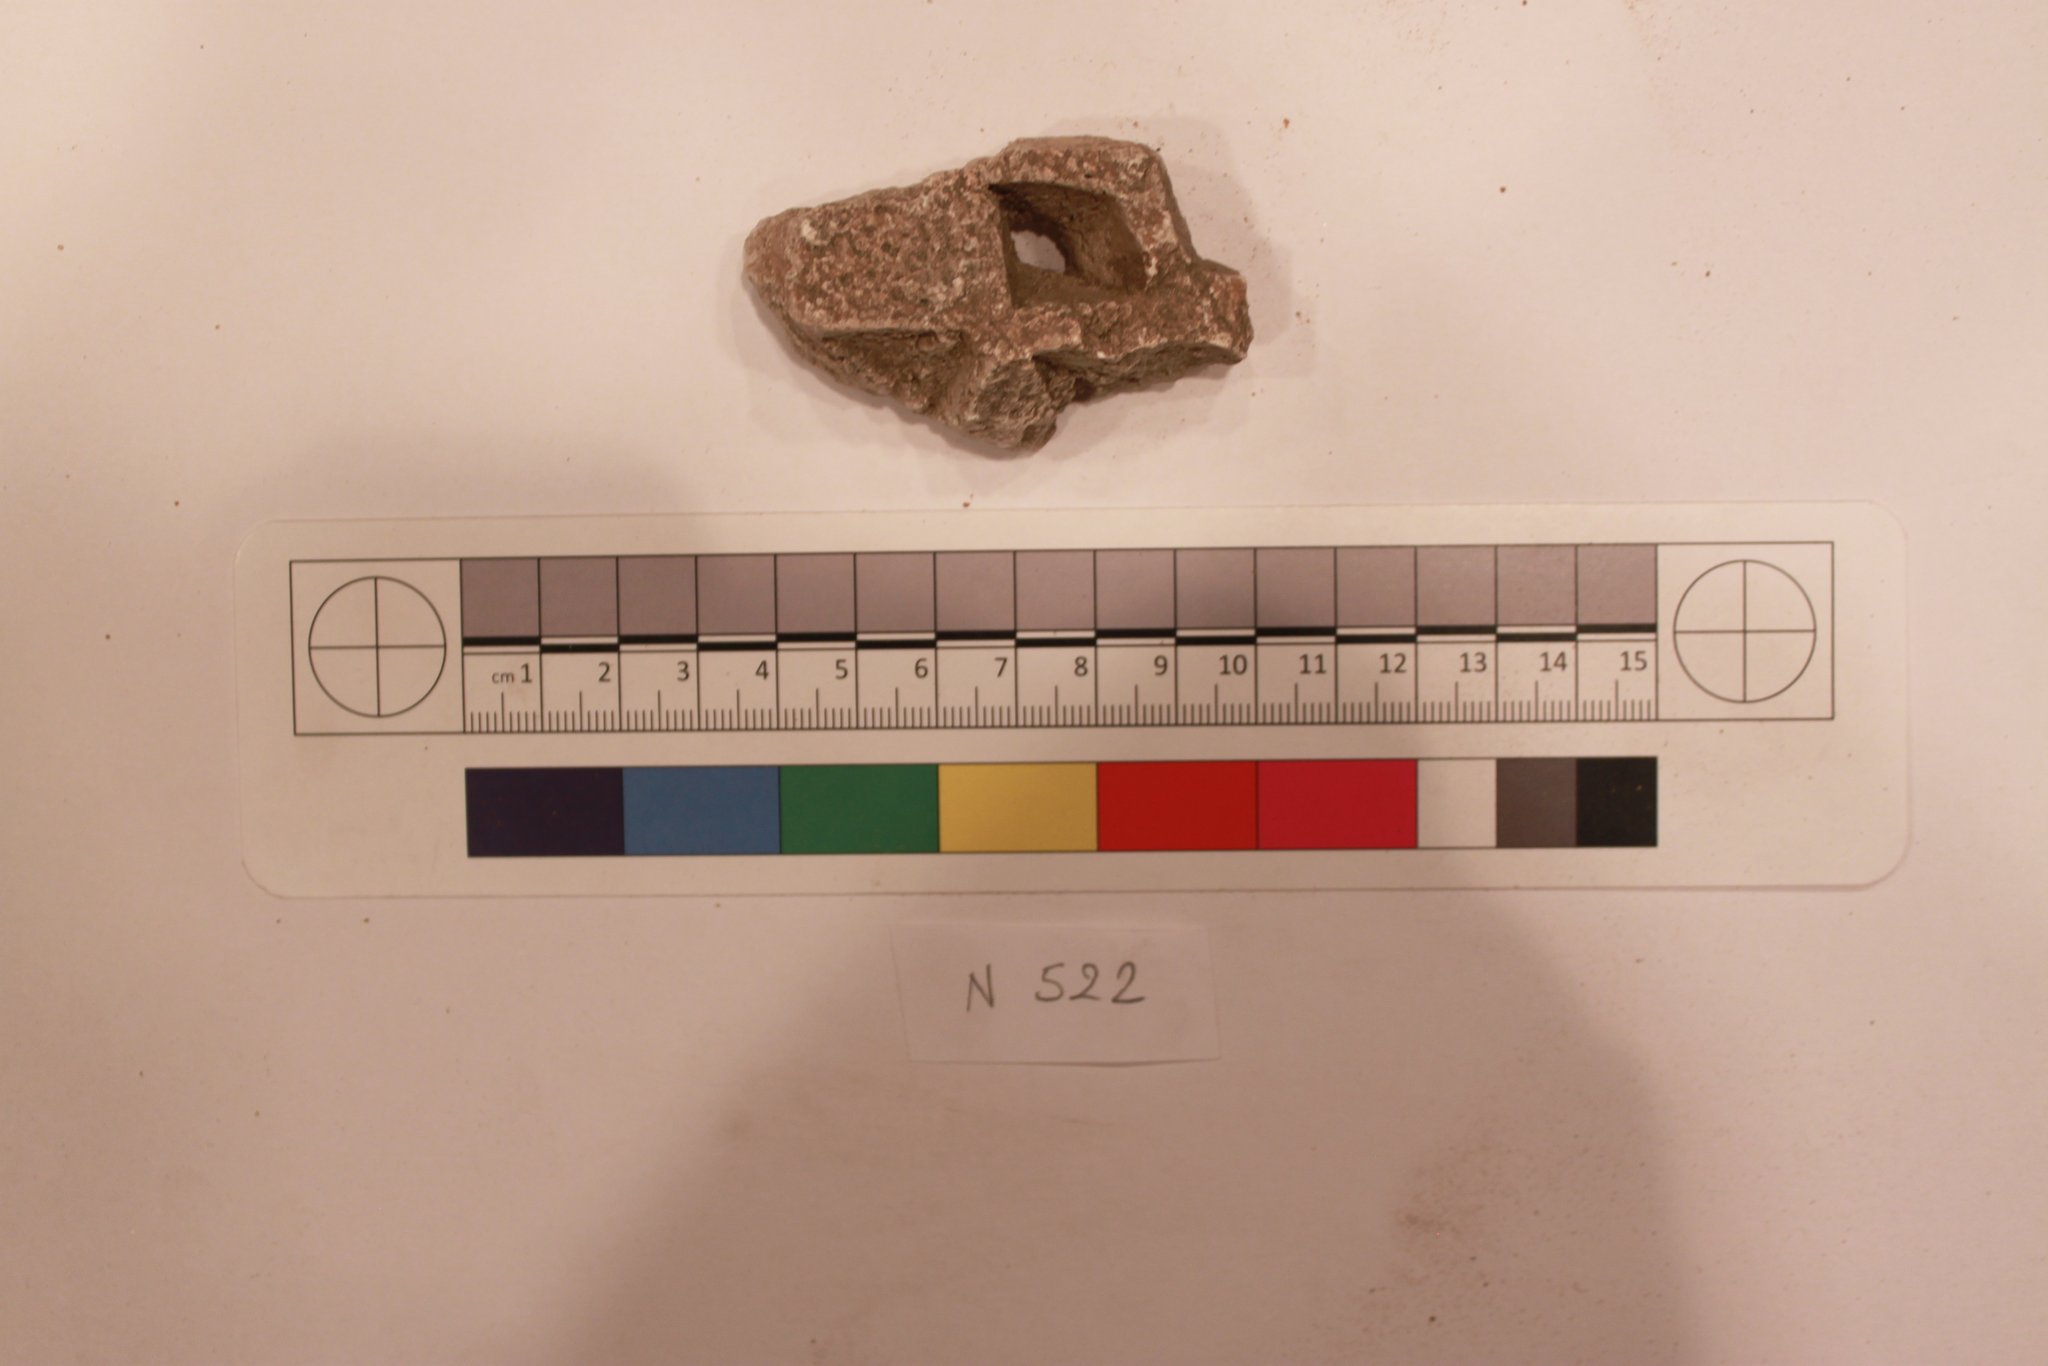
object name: fragment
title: Stucco Fragment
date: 701-1200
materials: plaster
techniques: carving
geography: iran